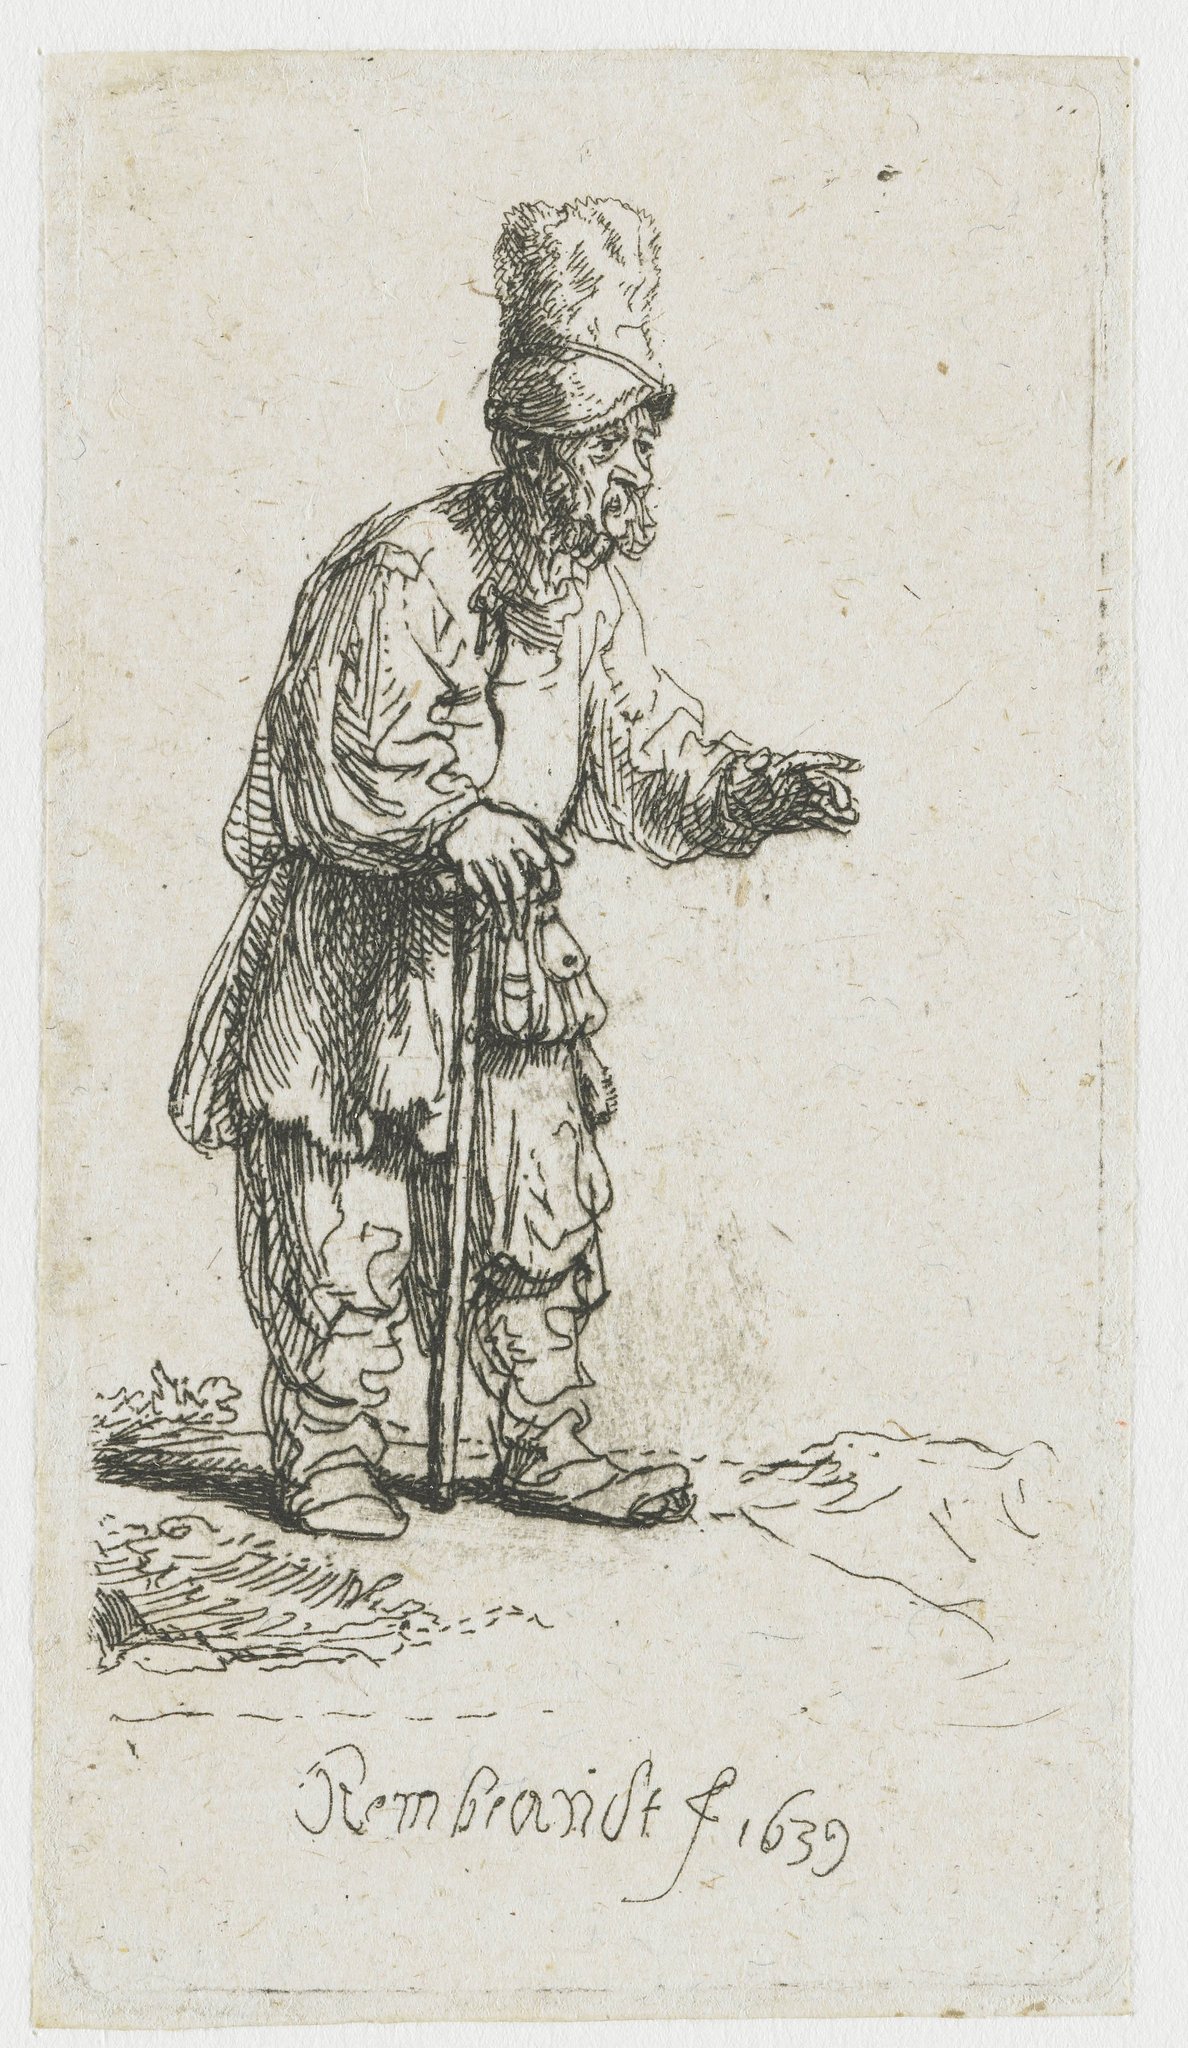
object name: print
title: A peasant in a high cap, standing leaning on a stick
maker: rembrandt van rijn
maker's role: draughtsman, painter, print maker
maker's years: 1606-1669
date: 1639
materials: paper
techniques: etching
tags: the ages of man (+ old male (human being))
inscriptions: mark: 2228, signature and date: ‘Rembrandt f. 1639’ Lugt